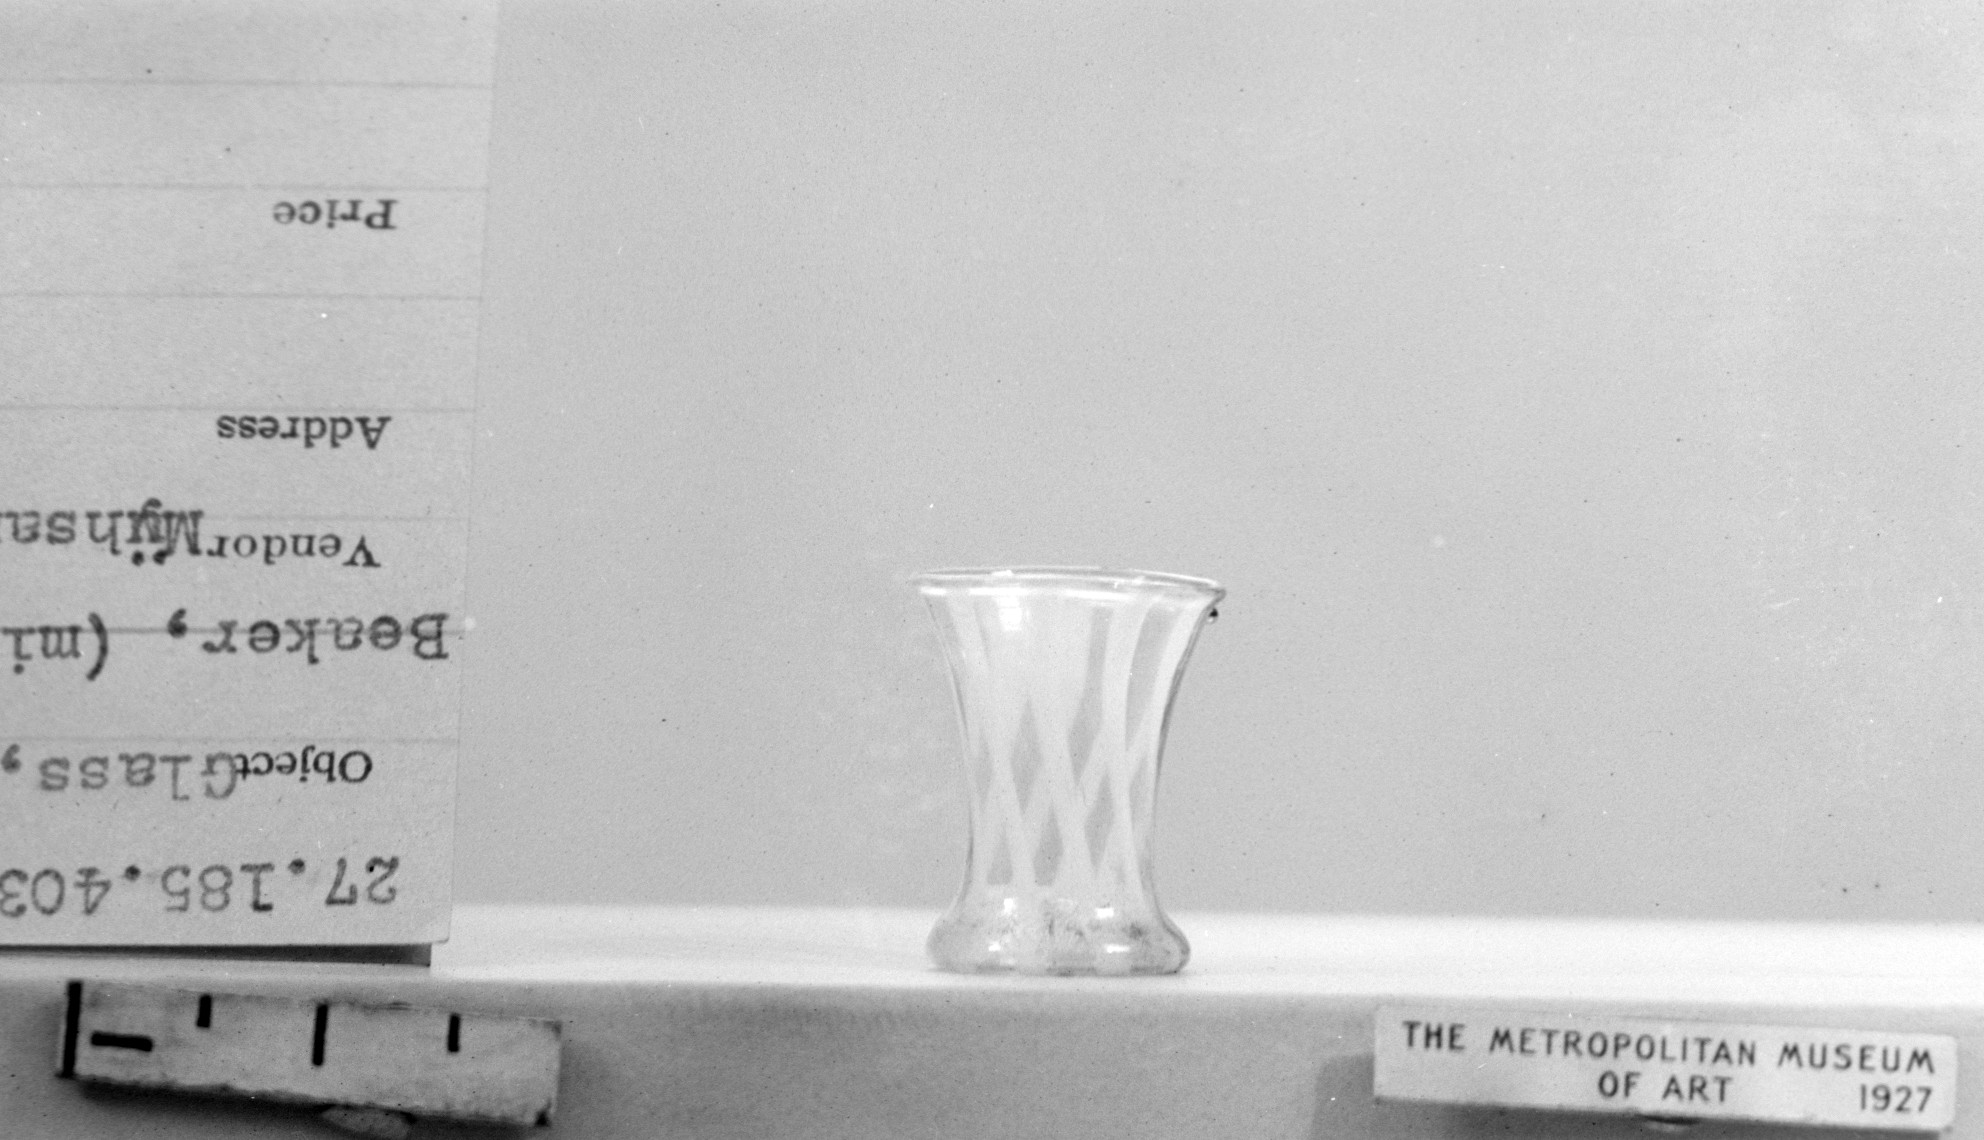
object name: beaker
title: Miniature beaker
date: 1801-1833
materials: glass